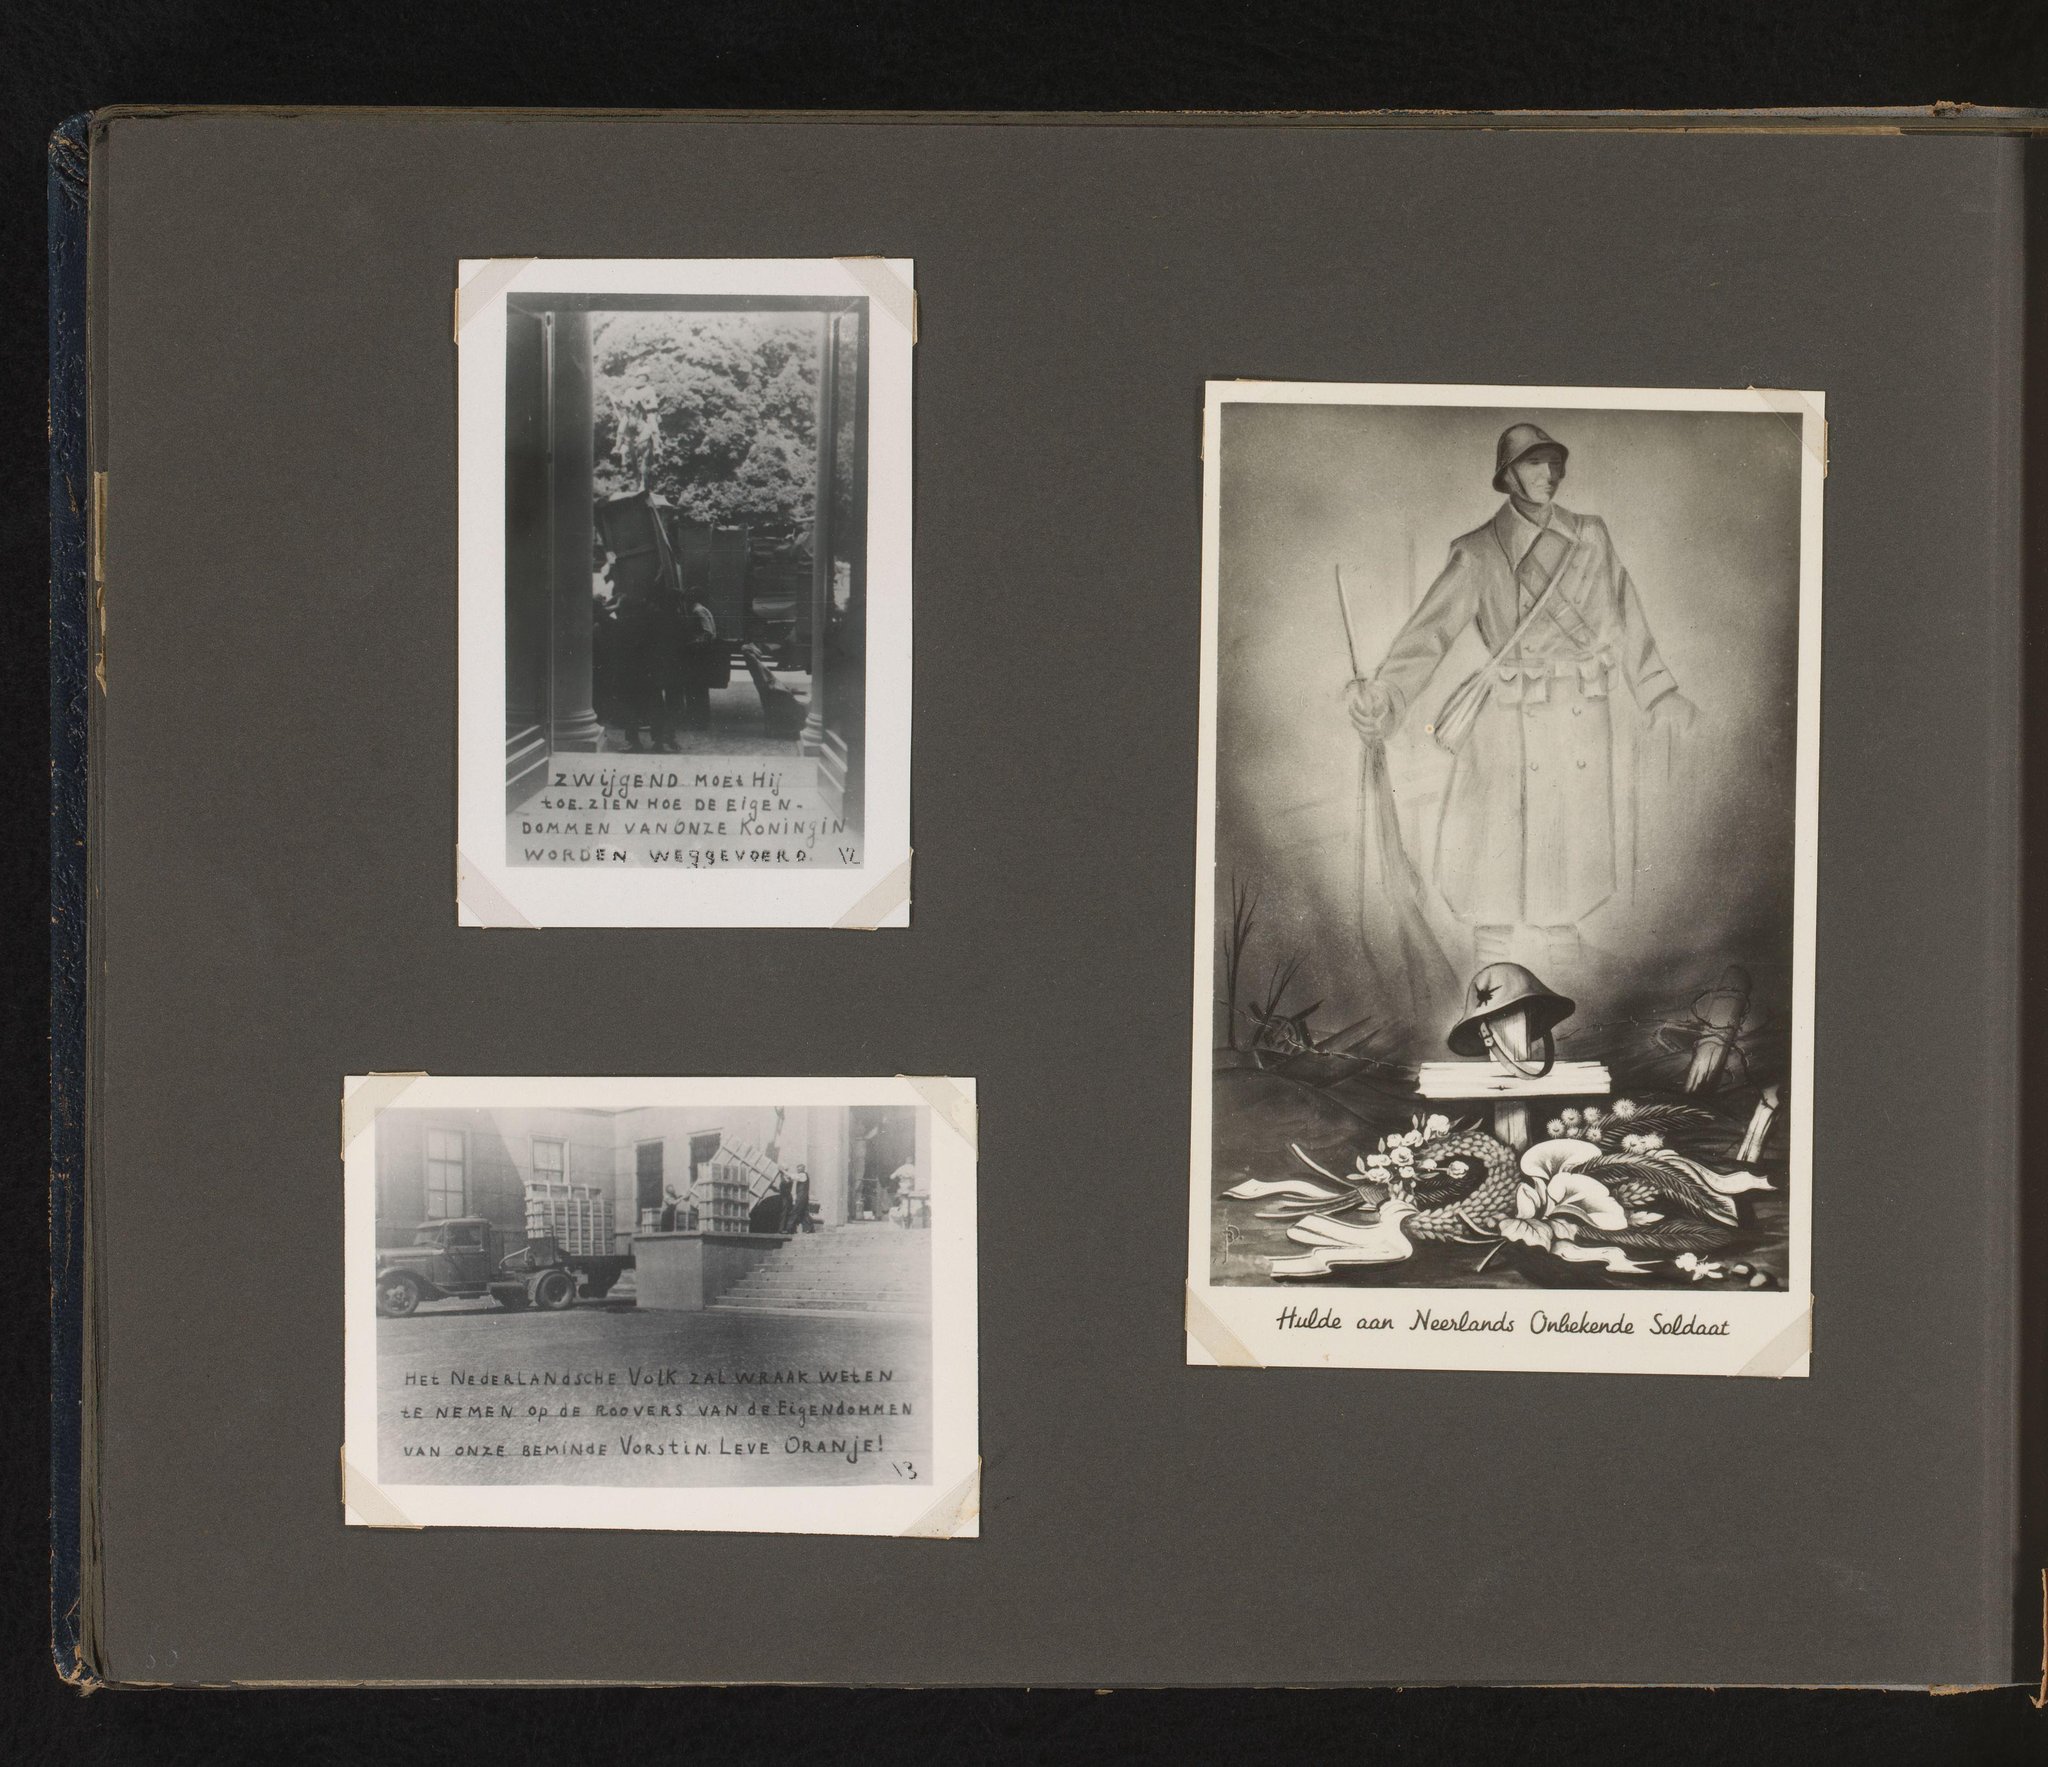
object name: photograph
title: Afvoer inventaris Paleis Noordeinde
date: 1940-1945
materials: cardboard, photographic support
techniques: gelatin silver print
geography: nijmegen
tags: plundering ~ soldiers, grave, tomb and other grave-forms and grave-markers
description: Albumblad met drie foto's van het afvoeren door de Duitsers van het inventaris van het Paleis Noordeinde en een eerbetoon aan de Nederlandse onbekende soldaat. Onderdeel van het fotoalbum over de familie van Oranje-Nassau ten tijde van de Tweede Wereldoorlog.